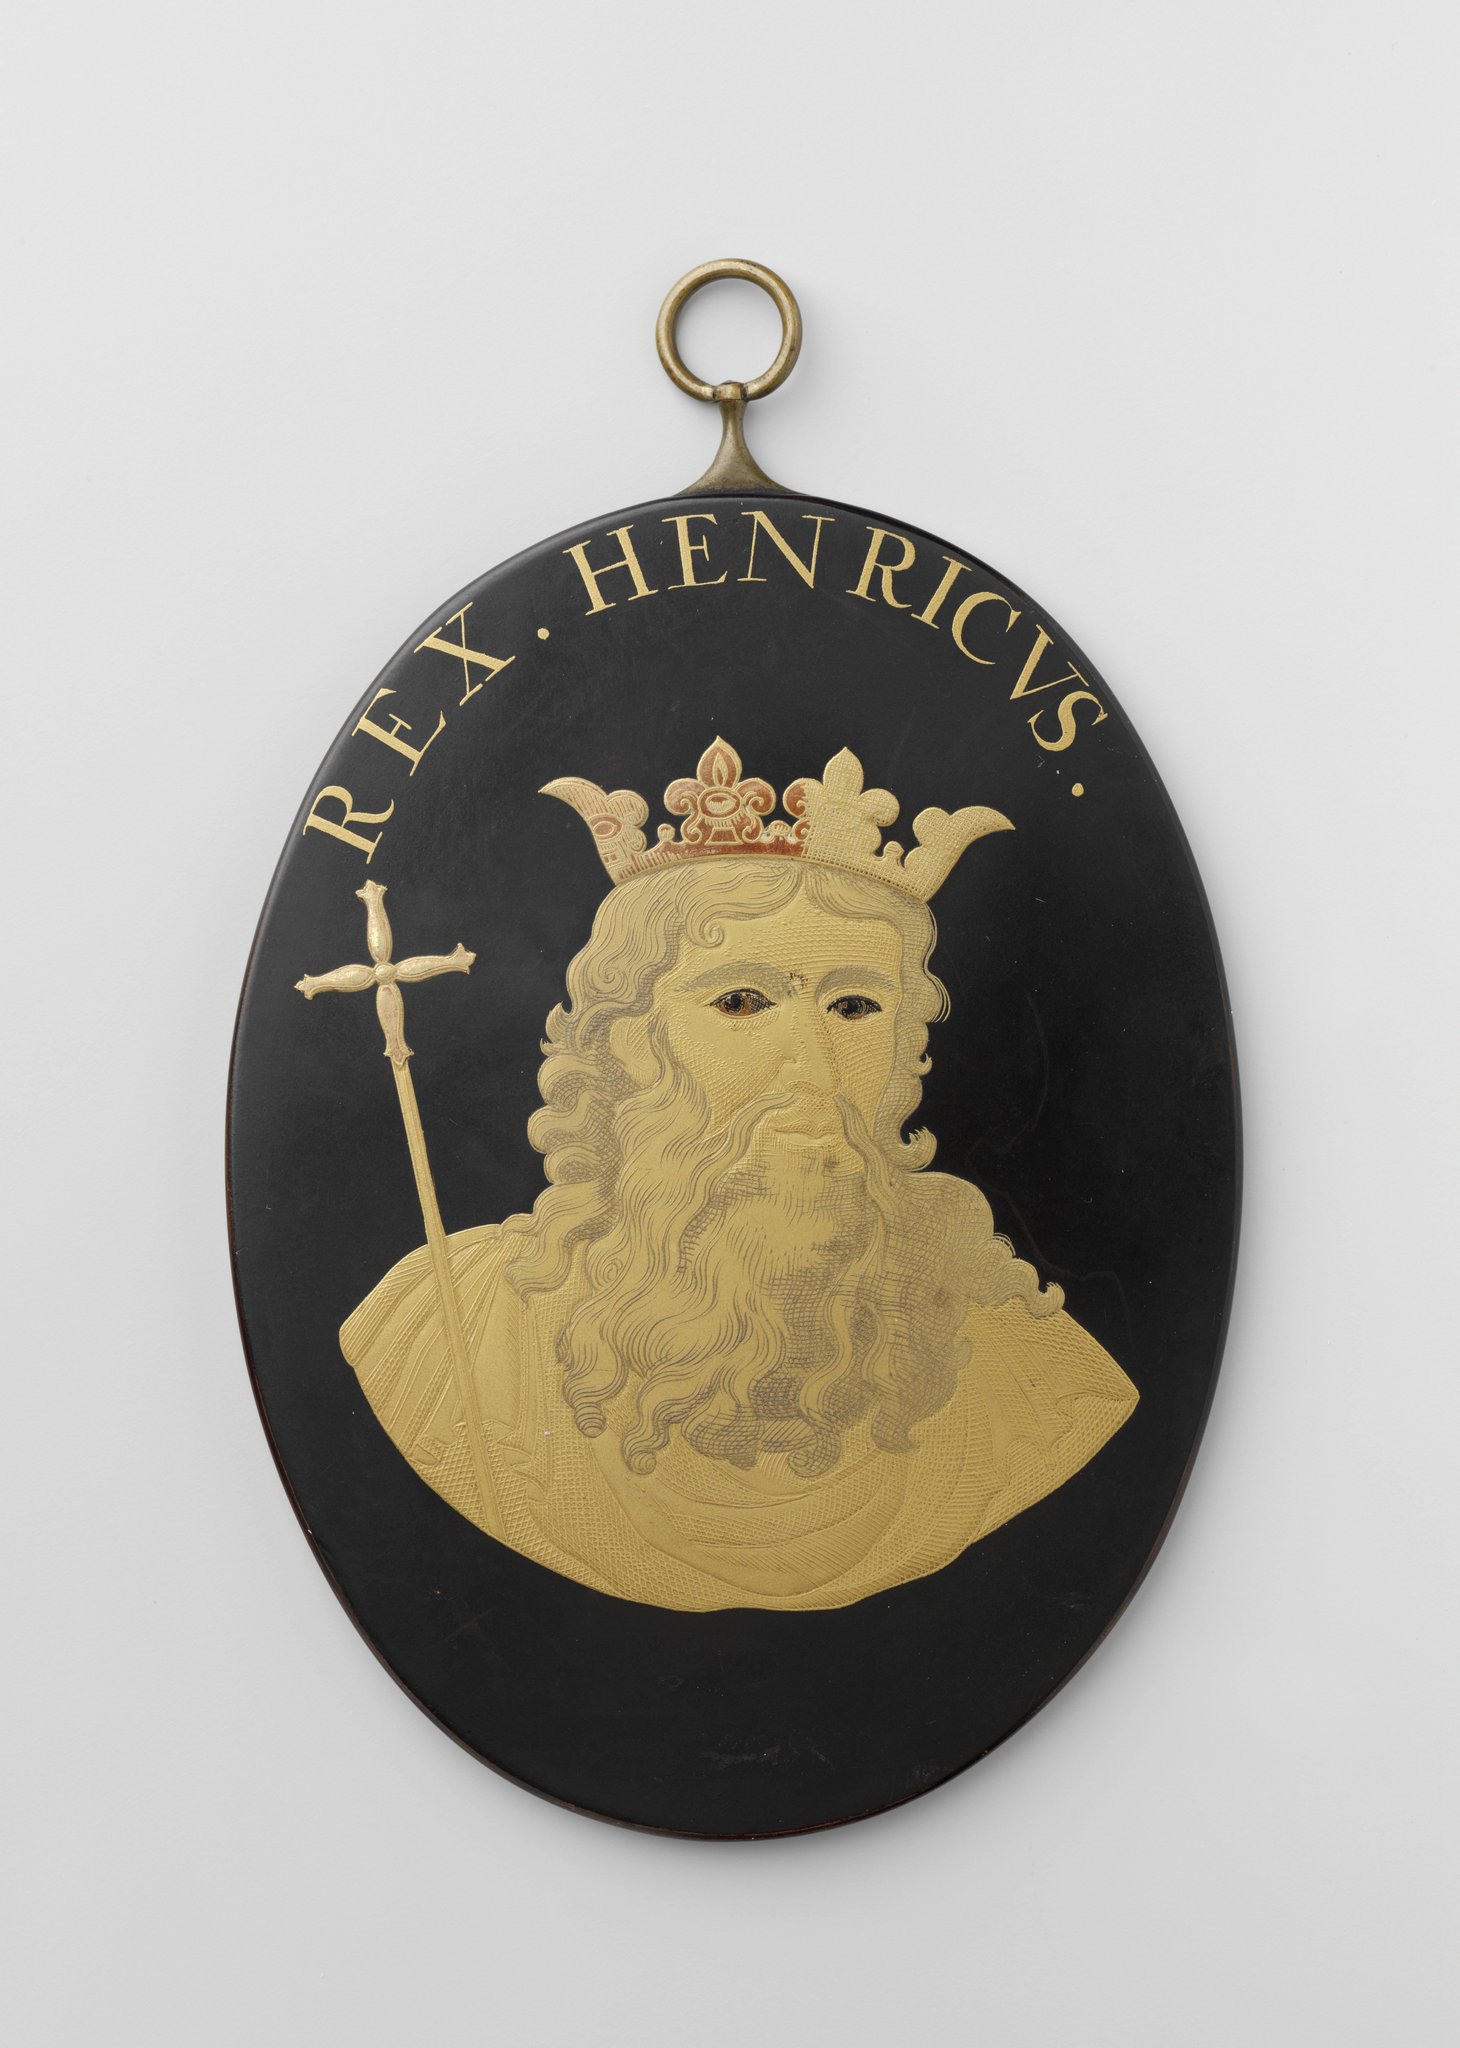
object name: plaque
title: Portret van koning Hendrik II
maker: Anonymous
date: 1775-1800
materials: copper, lacquer, paint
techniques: lacquer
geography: japan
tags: göttingen, keizer, koning, hendrik ii de heilige (keizer van het heilige roomse rijk)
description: Ovale plaquette met portret van een man, schouderstuk, met kroon en links een staf waarop een kruis. In goud op zwart, sporen van rood op de kroon, de ogen en het kruis, gouden randschrift boven: REX. HENRICVS. en keerzijde midden: HENRICVS II. Imp. an, XXII, mens V. di. XXI, sedentib. / Silvestro II,I.XVI,I.XVII, Sergio IV, Bened. VIII. et Ie XVIII / decess. an. Chr. MXXIV. Boven een draaibaar draagoog.